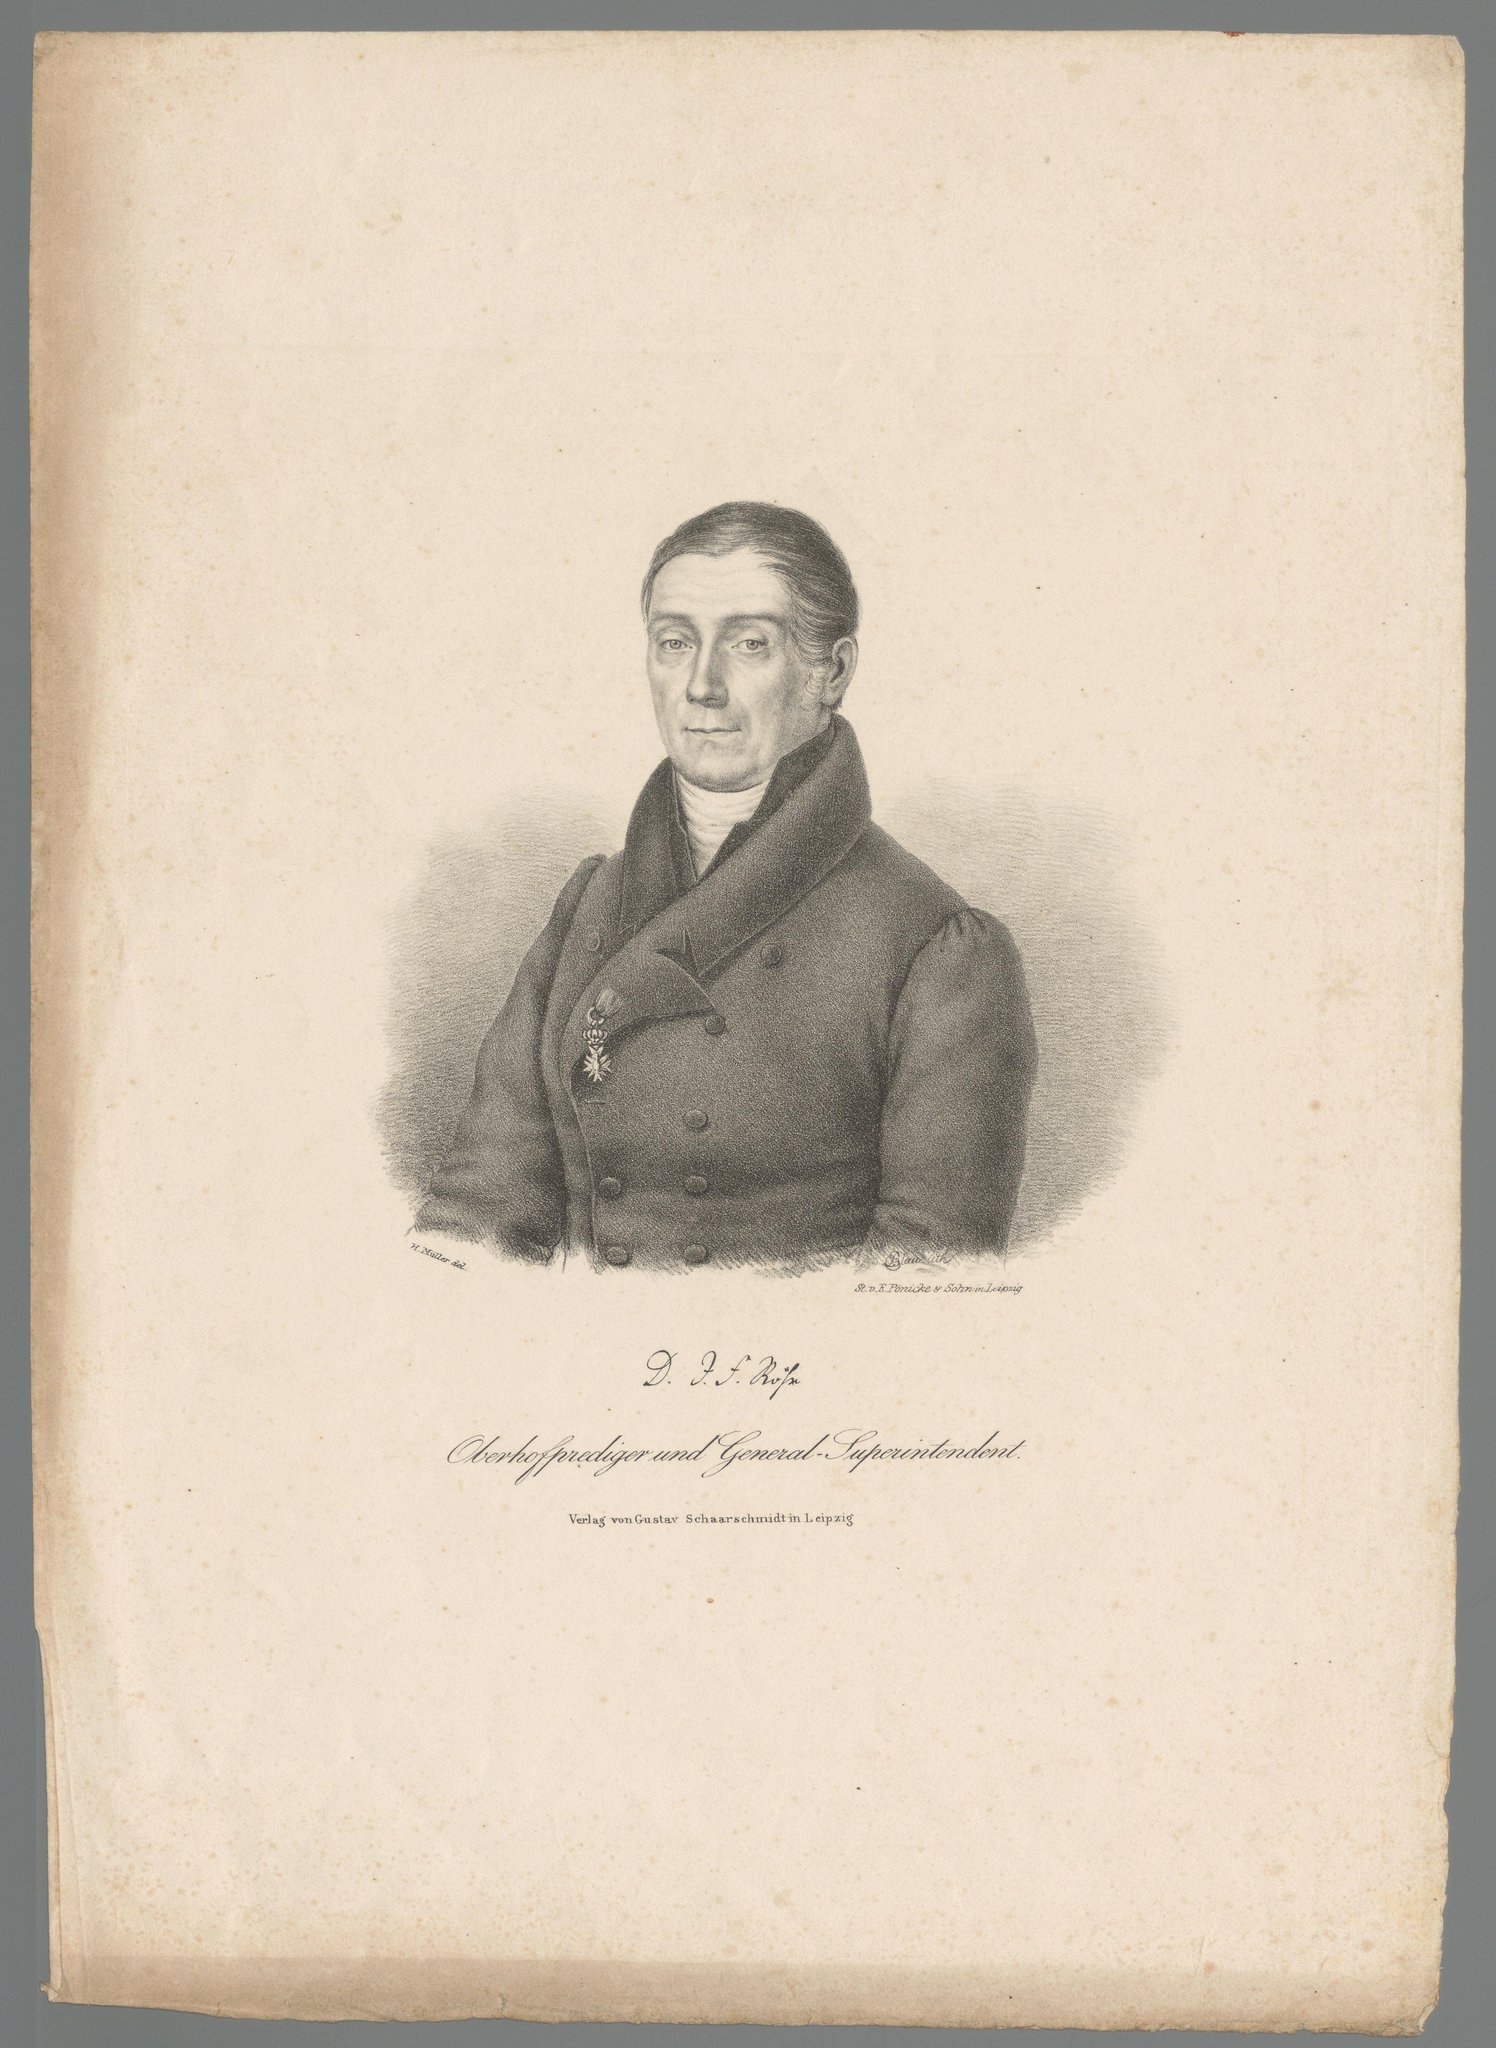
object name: print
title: D. J.F. Röhr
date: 1820-1850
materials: paper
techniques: lithograph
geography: leipzig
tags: adult man, historical persons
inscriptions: collector's mark: Lugt 2228